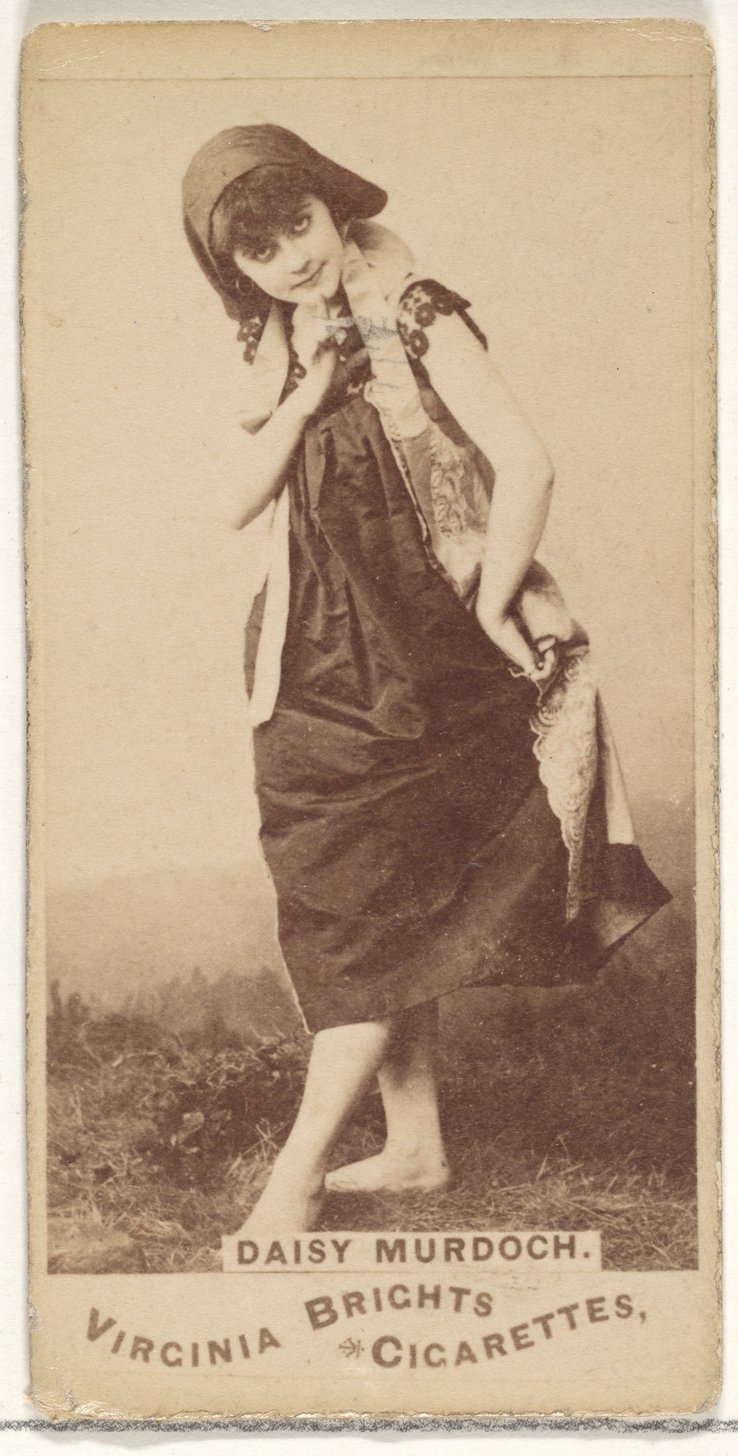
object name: photograph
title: Daisy Murdoch, from the Actors and Actresses series (N45, Type 1) for Virginia Brights Cigarettes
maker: allen & ginter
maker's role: publisher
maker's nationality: american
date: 1888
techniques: albumen silver print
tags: portraits,women,actresses